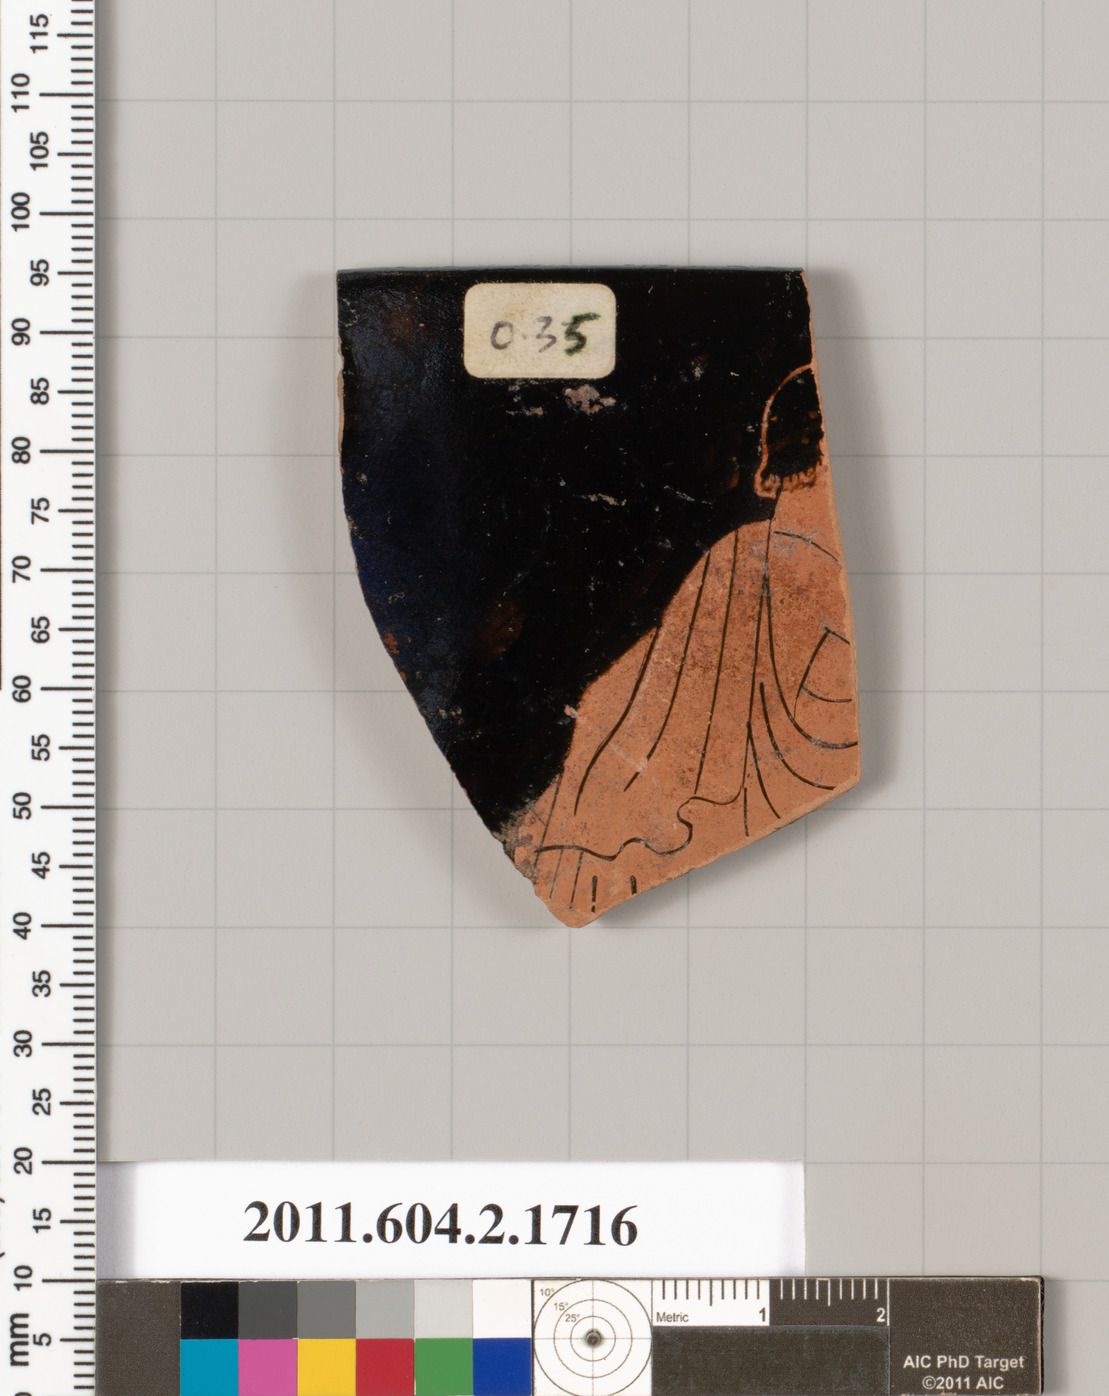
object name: skyphos fragment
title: Terracotta rim fragment of a skyphos (deep drinking cup)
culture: greek, attic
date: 480-470 BCE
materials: terracotta